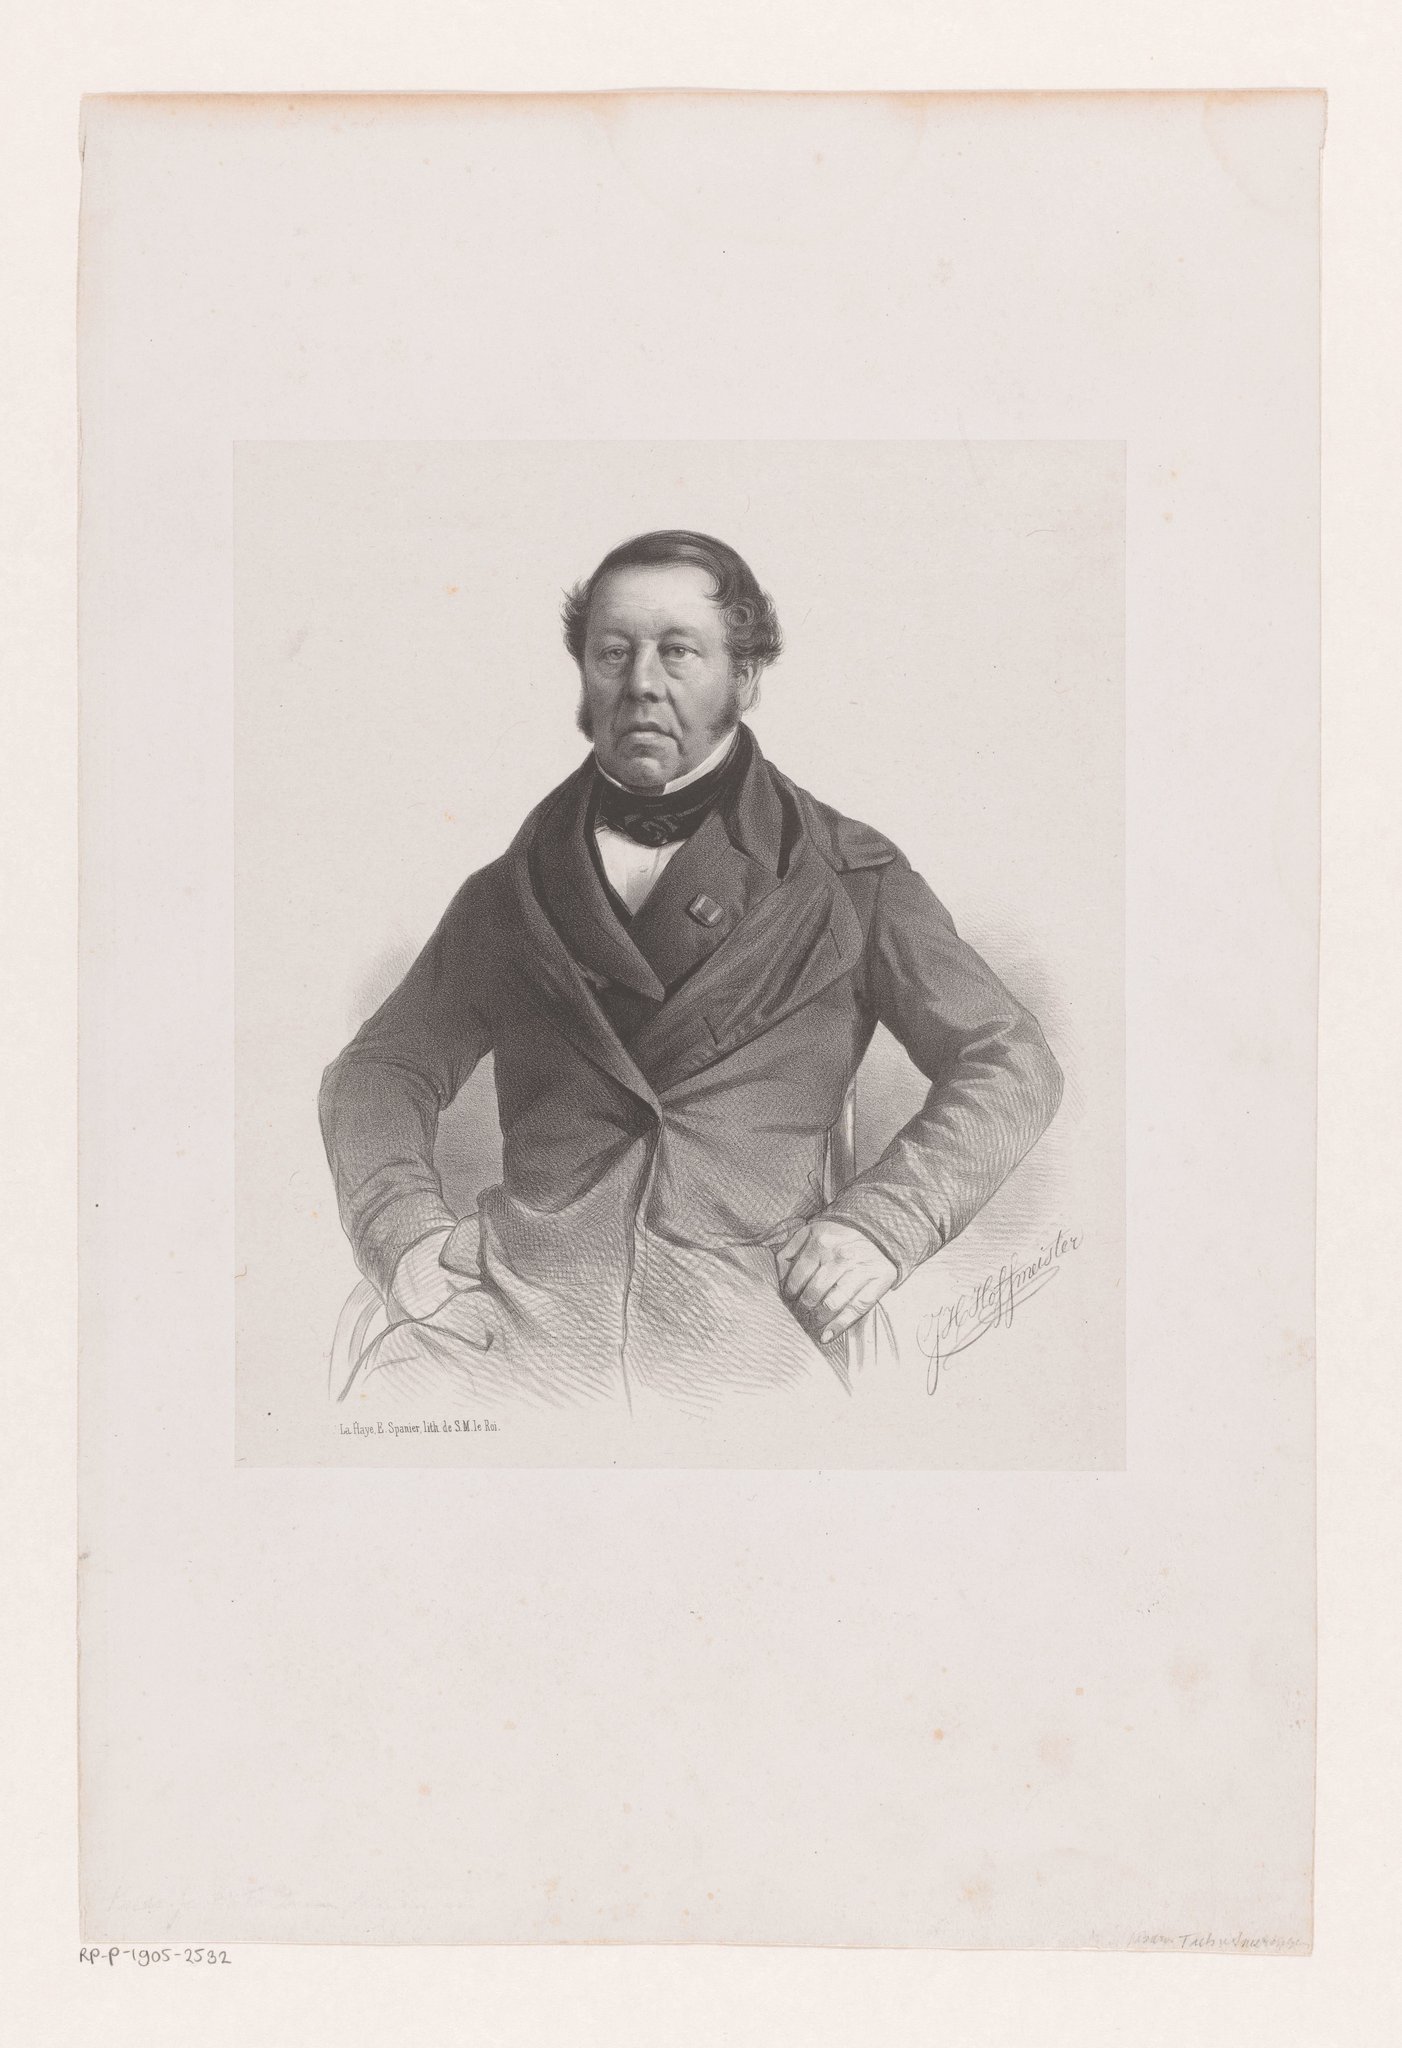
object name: print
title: Portret van Hendrik Jacob Taets van Amerongen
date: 1843-1863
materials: paper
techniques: lithograph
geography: the hague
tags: historical persons (+ half-length portrait)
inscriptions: collector's mark: Lugt 2228